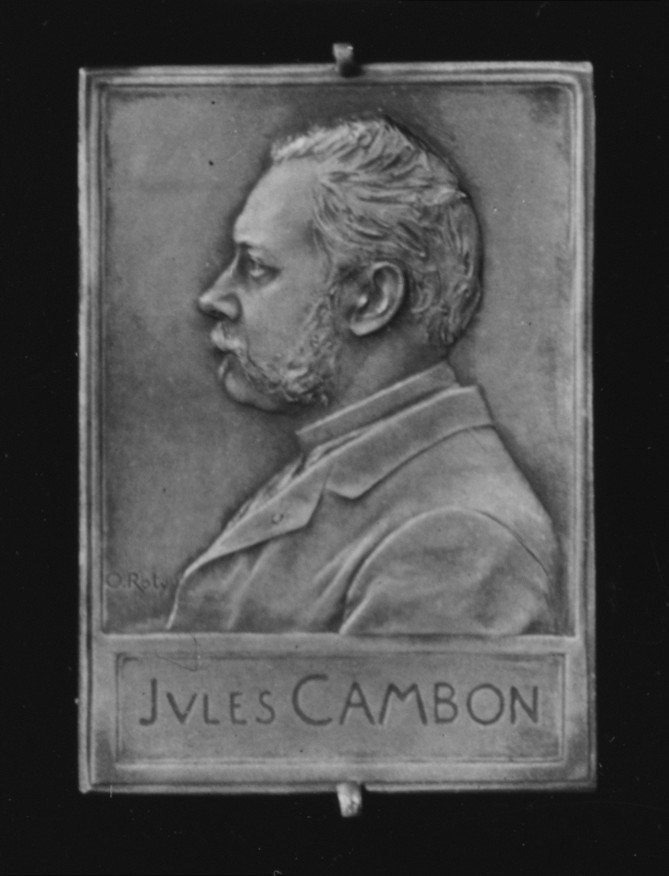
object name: plaquette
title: In Honor of M. Jules Cambon on his Appointment as Governor General of Algeria, 1891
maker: louis-oscar roty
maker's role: artist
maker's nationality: french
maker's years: 1846-1911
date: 1891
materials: bronze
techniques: silvered, struck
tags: men,profiles